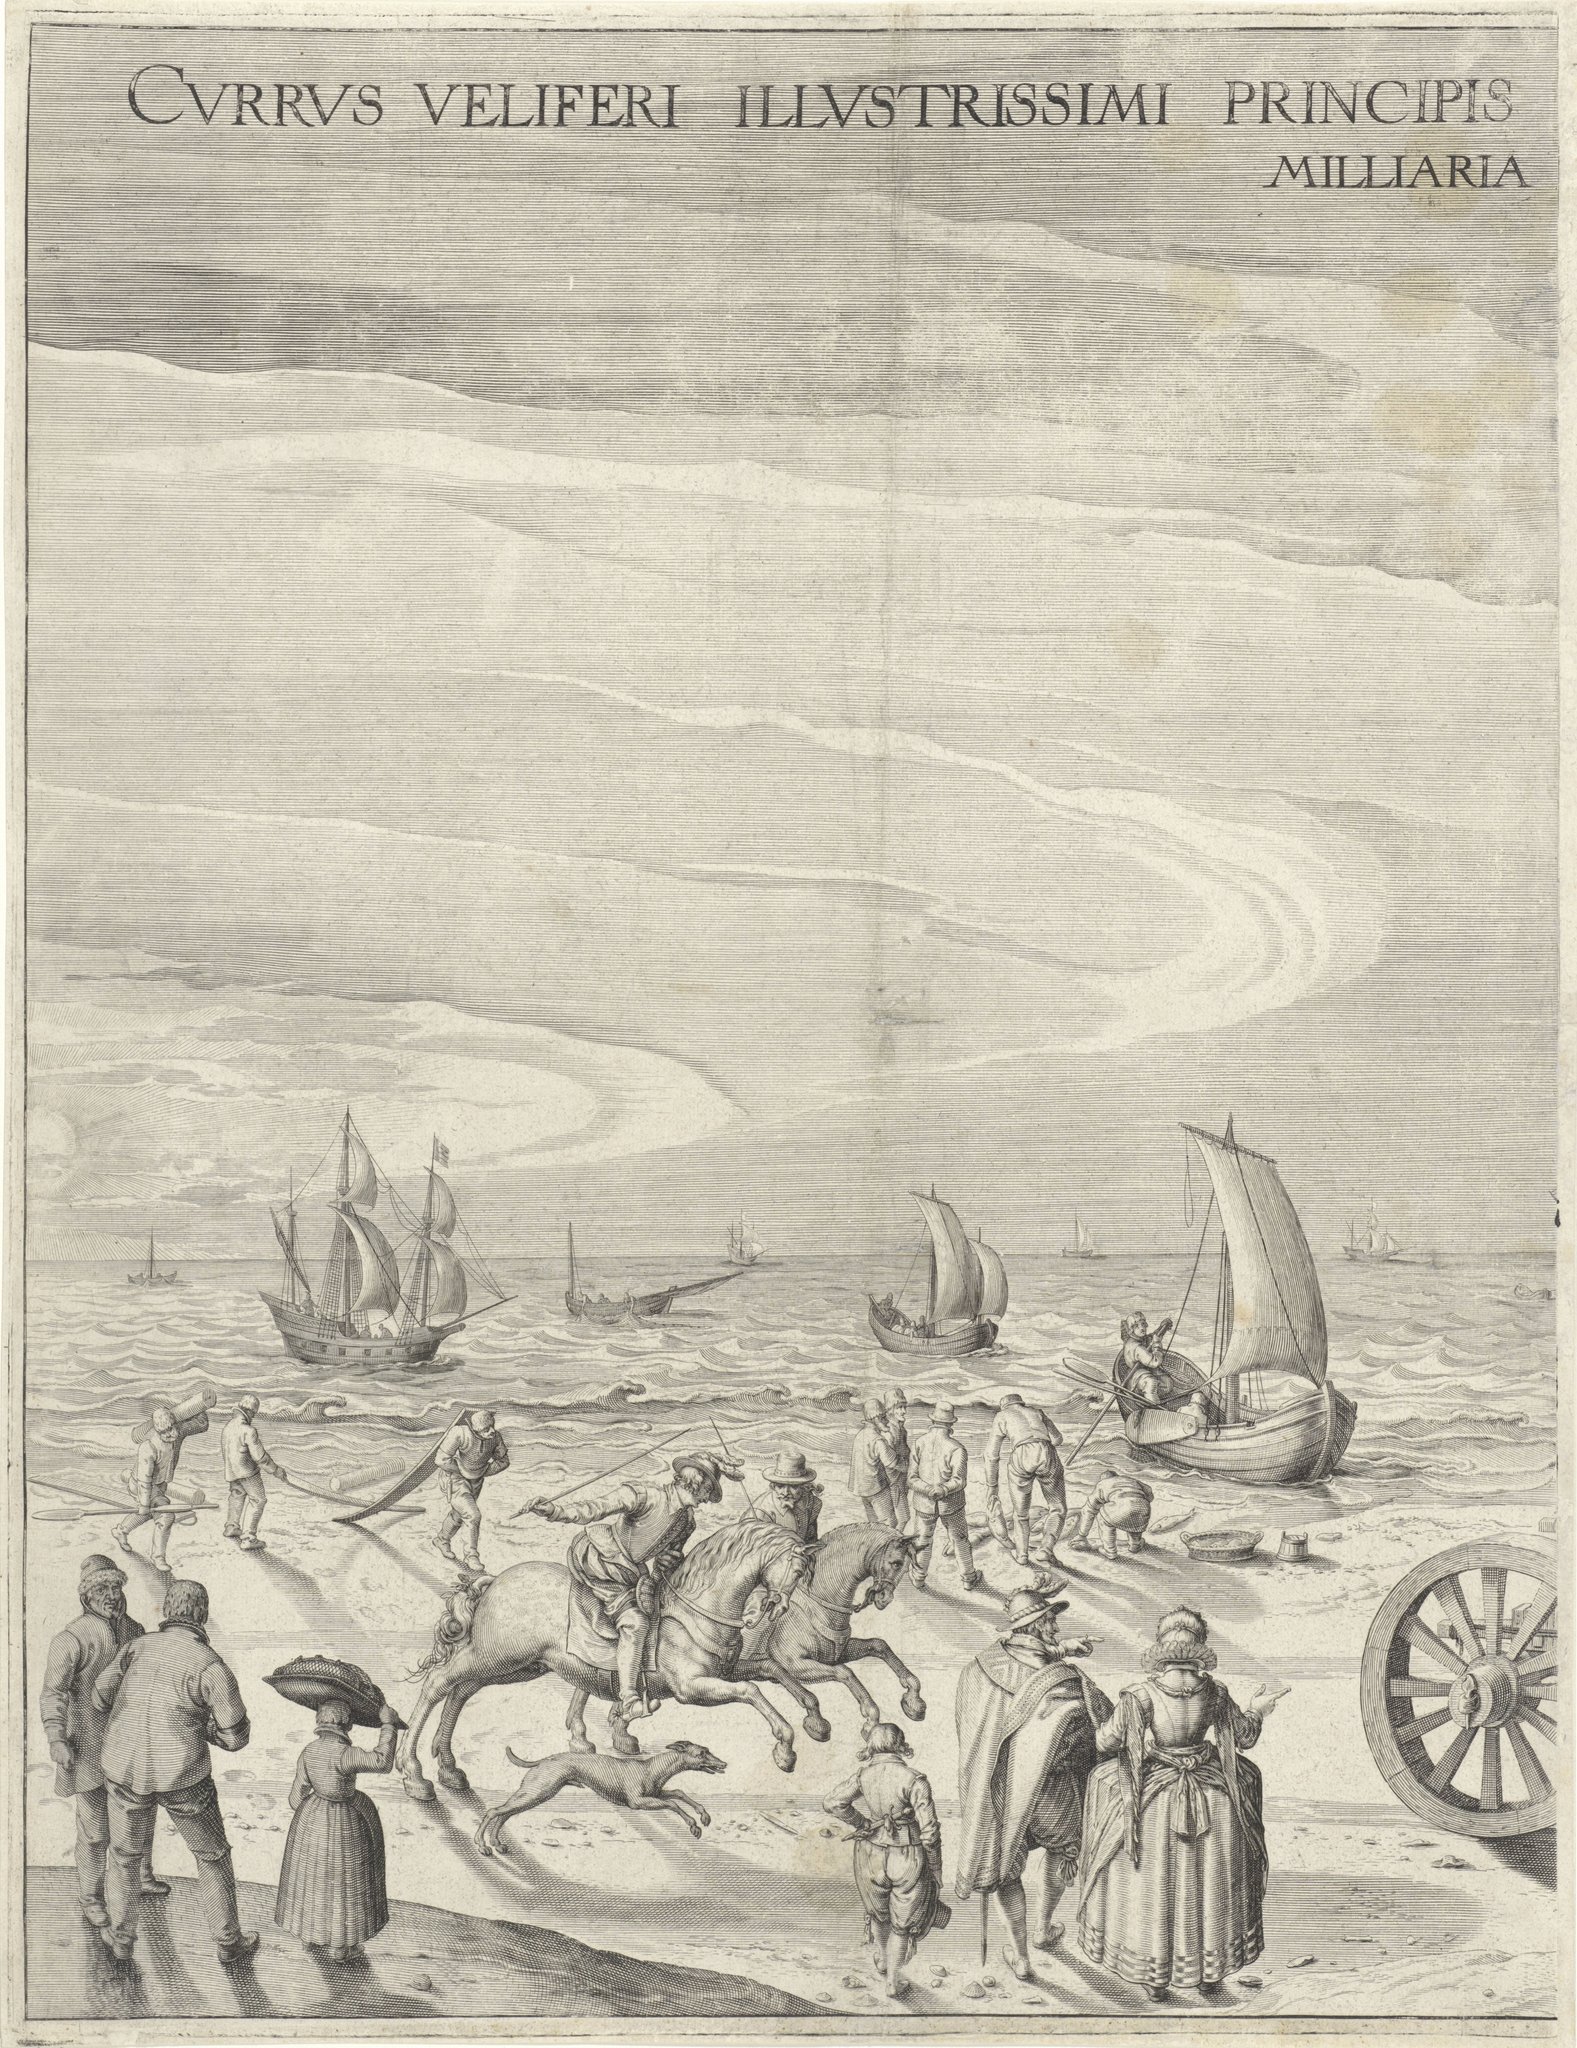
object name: print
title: De zeilwagen van Simon Stevin (linkerplaat), 1602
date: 1603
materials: paper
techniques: engraving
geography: leiden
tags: the hague, maurice (prince of orange), bruges, simon stevin, sailing-car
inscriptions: collector's mark: Lugt 2228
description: De zeilwagen van Simon Stevin (linkerplaat), 1602. Prins Maurits maakt samen met een groep vrienden een tocht over het strand van Scheveningen naar Petten in de zeilwagen gebouwd door Simon Stevin, april-mei 1602. Vóór de toevoeging van de grote cartouche. Op het strand toeschouwers, vissers en twee ruiters. Linkerplaat van een grote voorstelling bestaande uit drie delen.